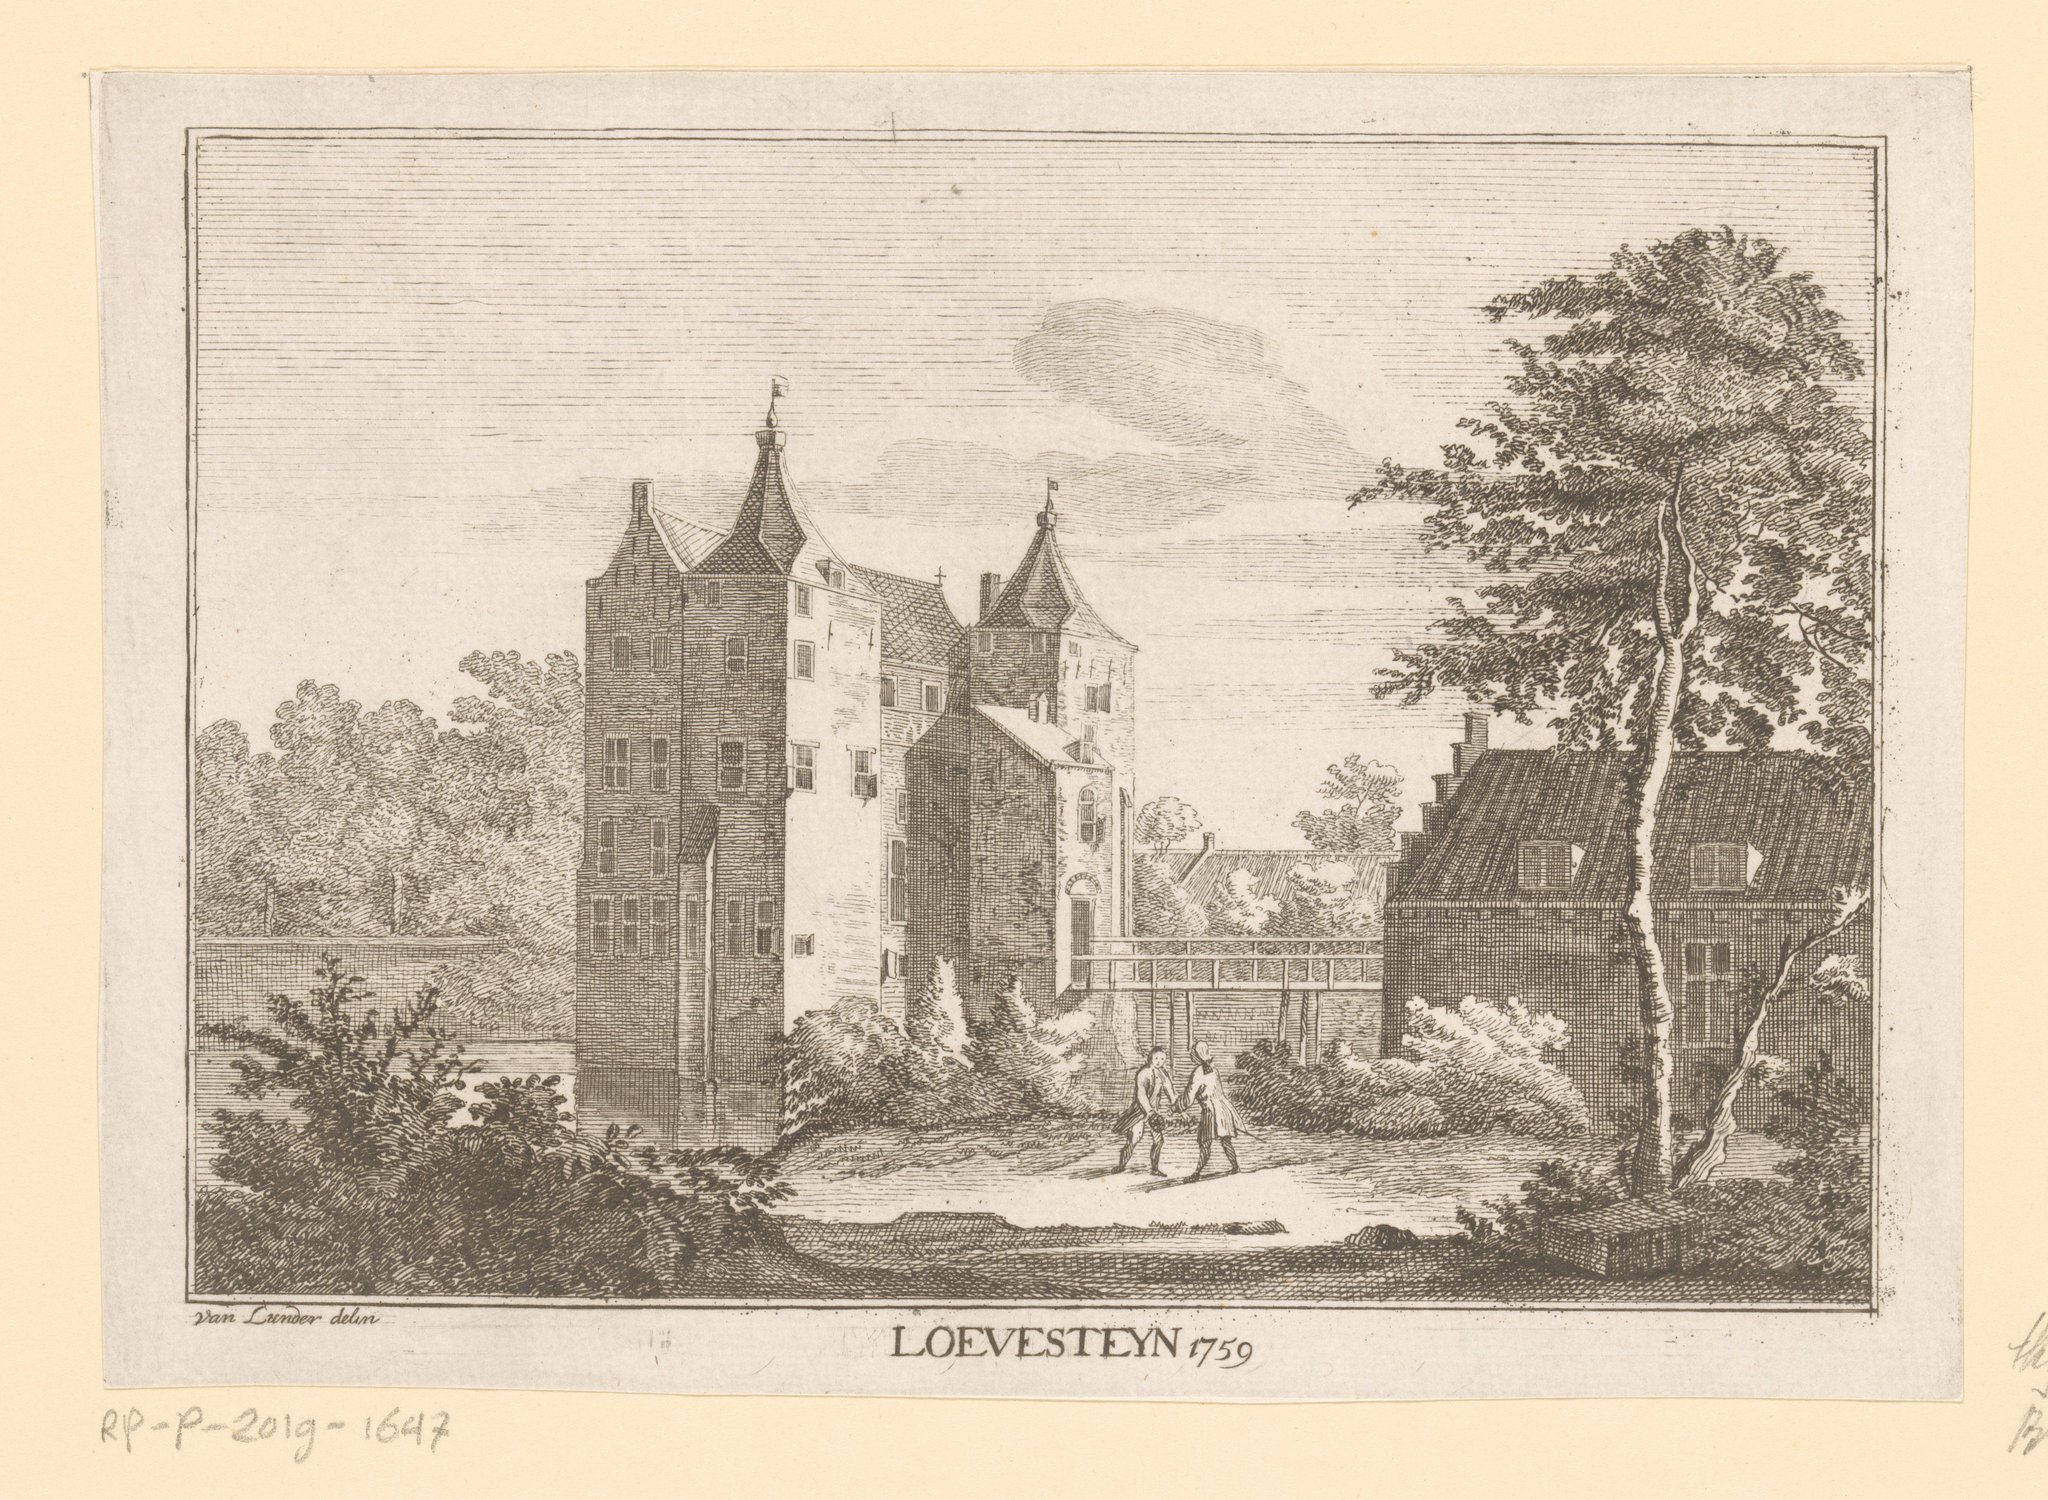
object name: print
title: Loevesteyn 1759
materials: paper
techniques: etching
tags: castle, landscape with tower or castle (+ city(-scape) with figures, staffage), loevestein castle